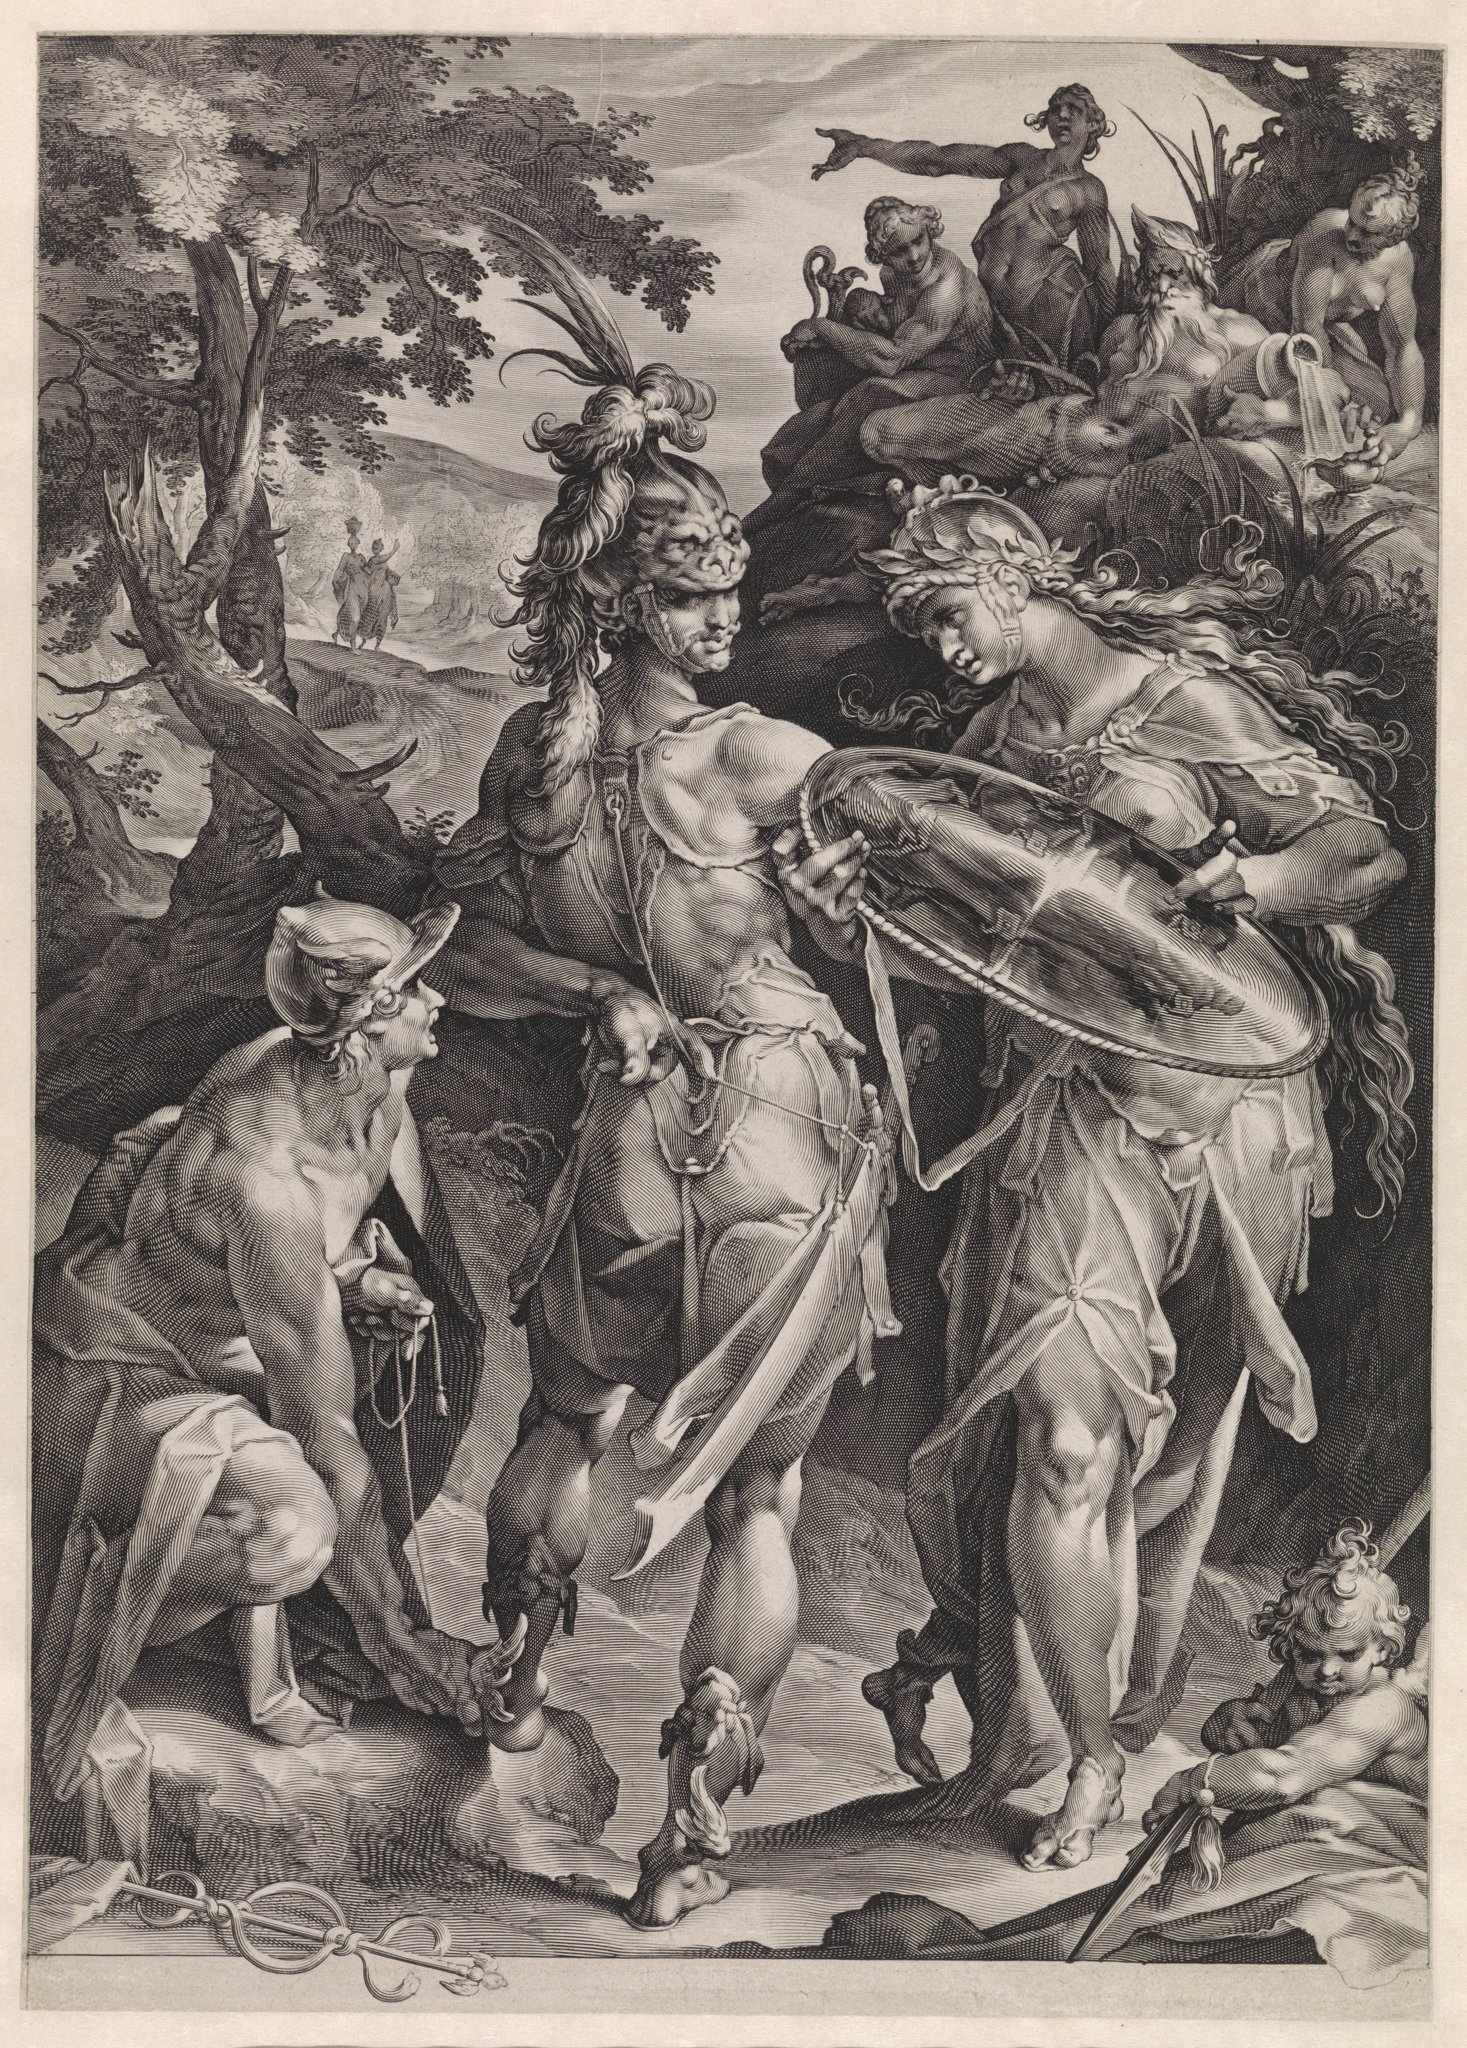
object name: print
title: Minerva en Mercurius bewapenen Perseus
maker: jan harmensz. muller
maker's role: draughtsman, print maker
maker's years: 1571-1628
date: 1604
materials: chalk, paper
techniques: engraving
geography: amsterdam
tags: the gods arm perseus; from minerva, mercury and/or other gods he gets a shield (or mirror), a scythe (or dagger), a helmet, winged sandals, and a wallet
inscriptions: collector's mark: Lugt 2228, collector's mark: Lugt 1494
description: Minerva en Mercurius bewapenen Perseus, voordat hij Medusa zal bevechten. Minerva geeft hem haar schild en Mercurius bindt zijn gevleugelde sandalen aan de voeten van Perseus.